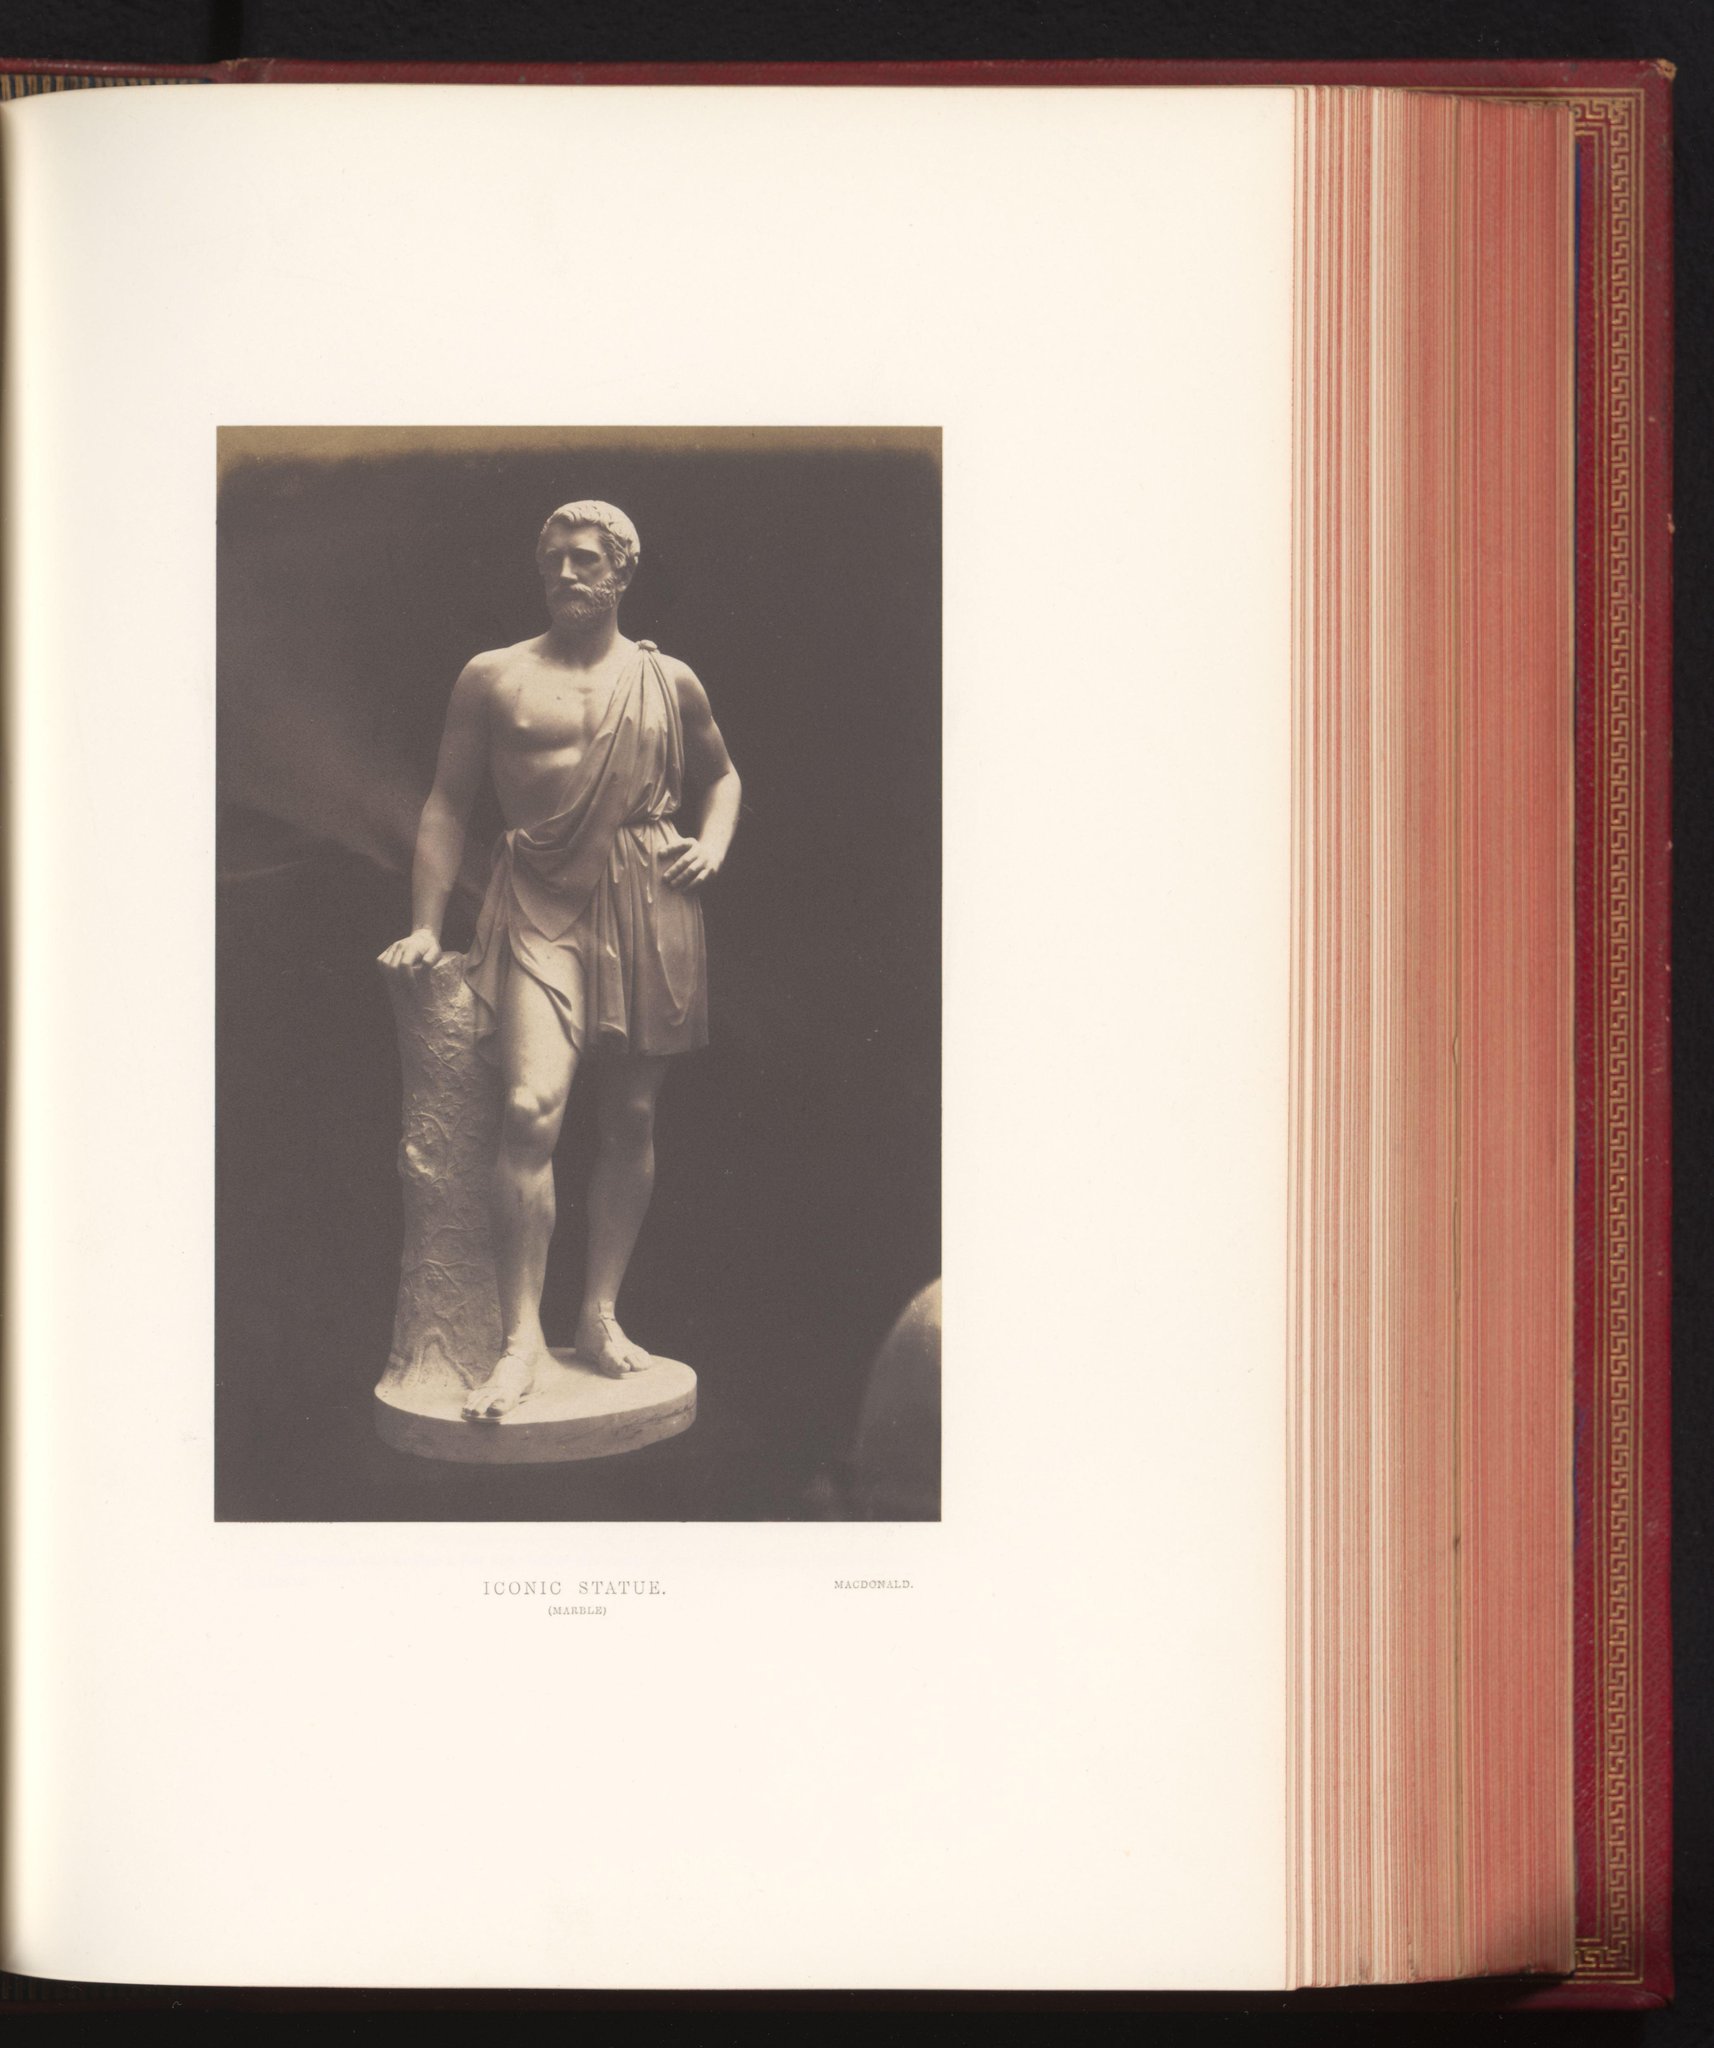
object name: page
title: Iconic Statue. (Marble) MacDonald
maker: Anonymous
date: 1851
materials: photographic support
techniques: salted paper print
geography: london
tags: piece of sculpture, reproduction of a piece of sculpture, london